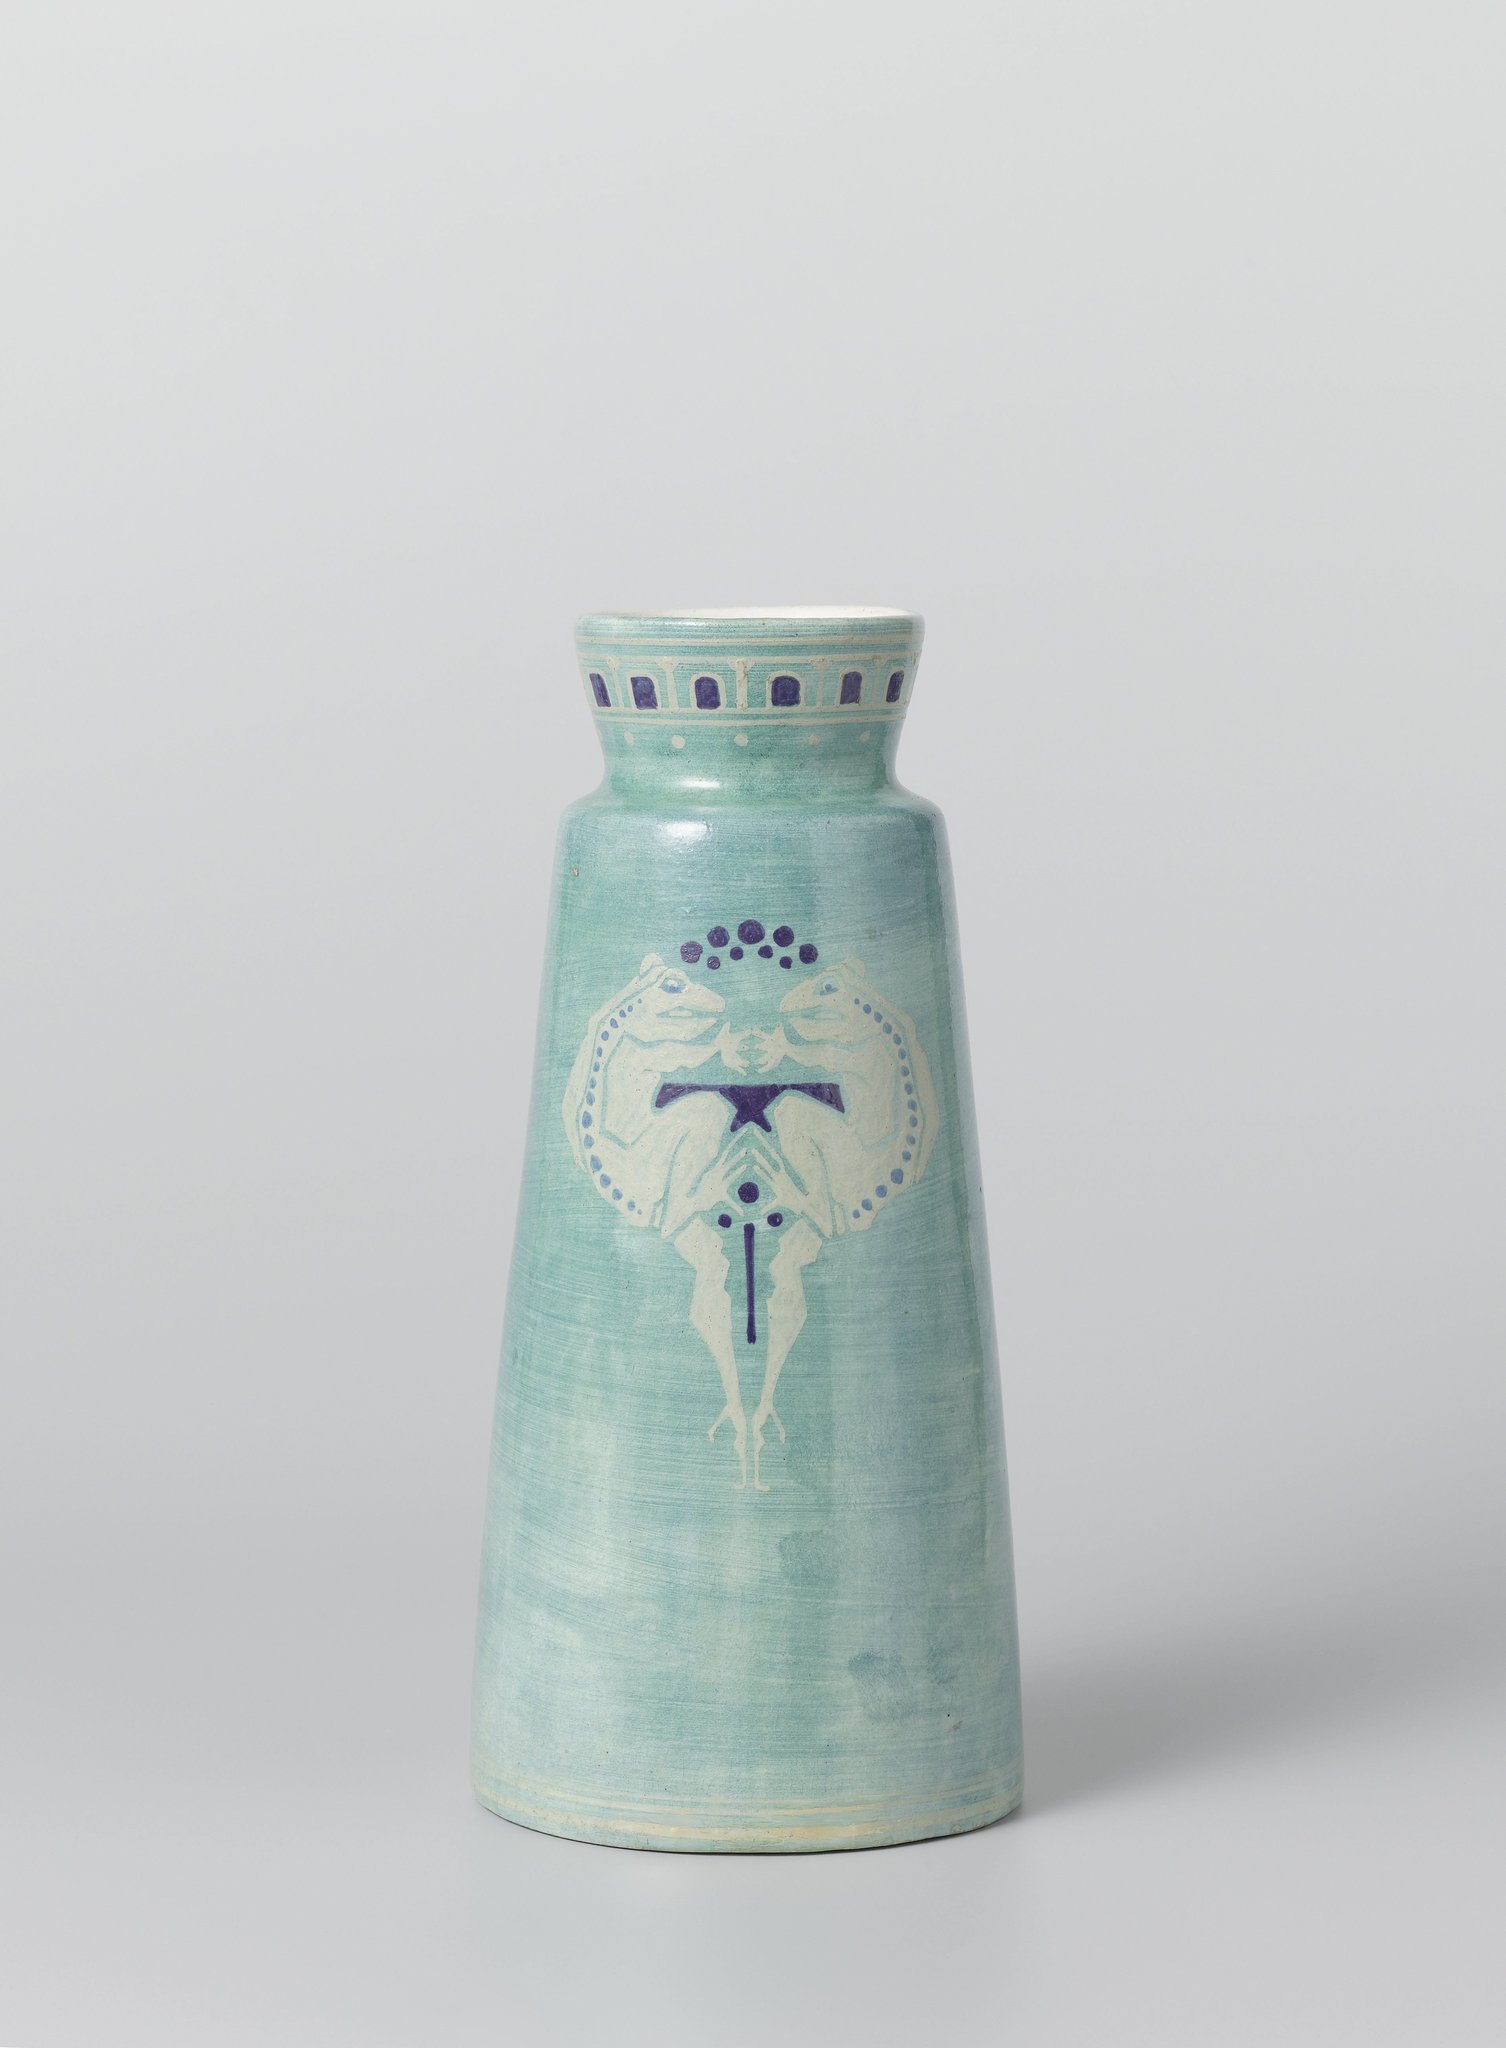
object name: vase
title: Vaas beschilderd met twee naar elkaar toegewende kameleons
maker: johannes van der vet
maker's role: designer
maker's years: 1879-1954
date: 1903-1908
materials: earthenware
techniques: painted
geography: dordrecht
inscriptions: mark: ‘5. // D K P. // Dordrecht. // Holland. // J.v.d.V’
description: Vaas van aardewerk, beschilderd met twee naar elkaar toegewende kikkers in wit, licht- en donkerblauw op blauwgroene fond, die de vaas geheel bedekt.